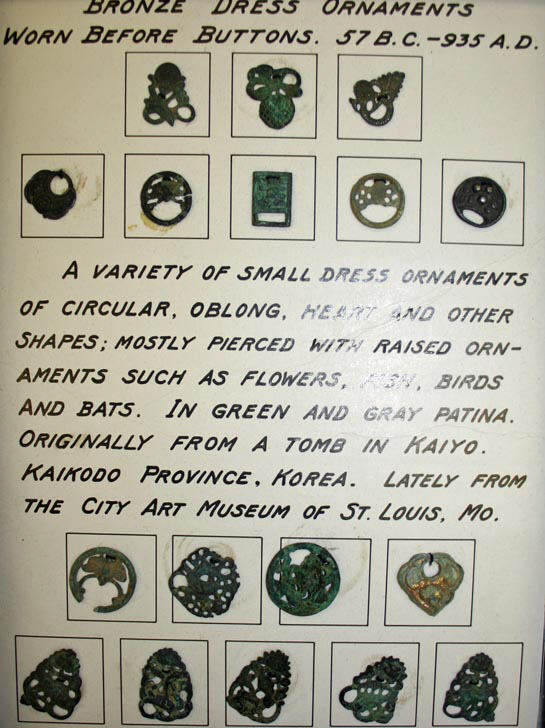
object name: button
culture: korean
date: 57 BCE-935 CE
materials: bronze